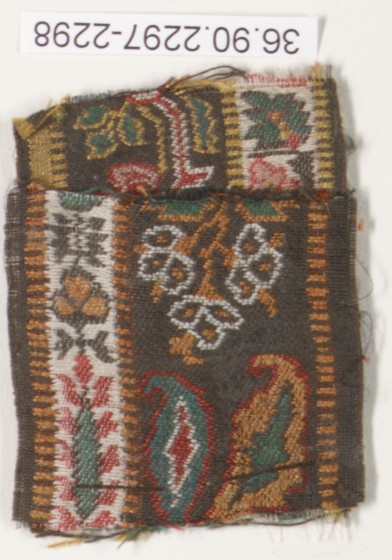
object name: border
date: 1801-1900